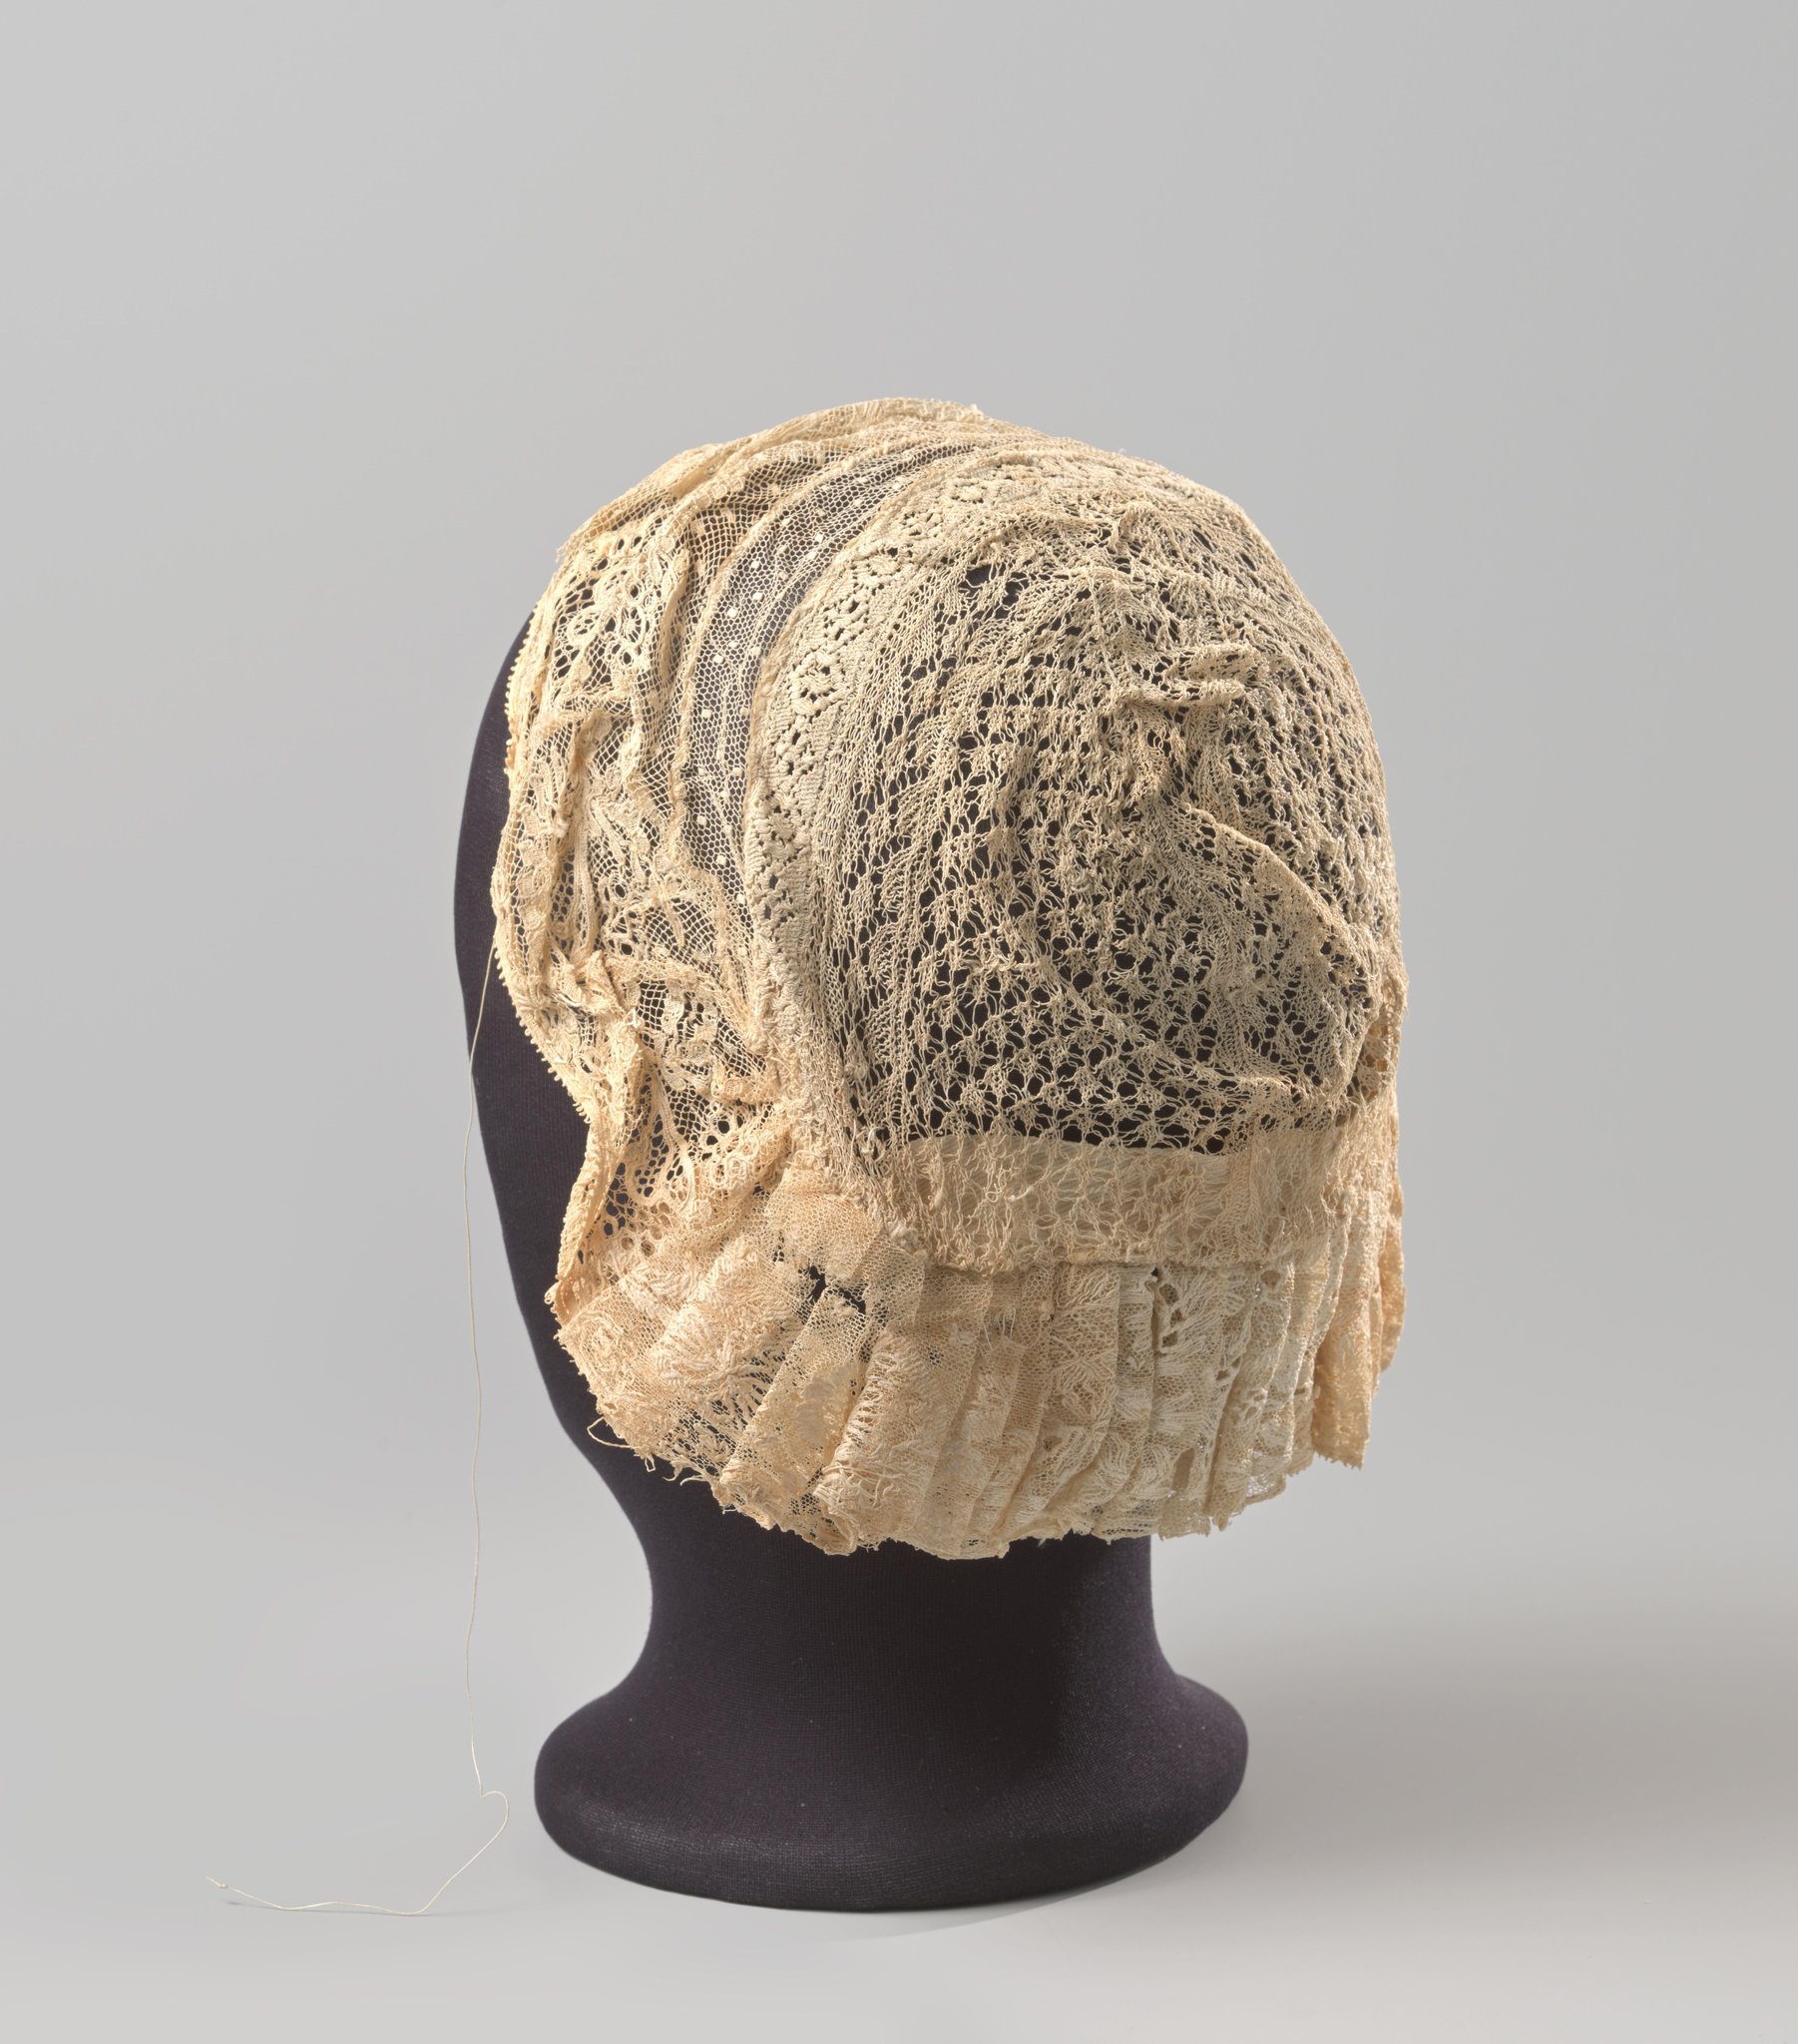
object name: womenswear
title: Muts met bol van Friese kant in fijn breiwerk, afgezet met een strook Rijsselse kant dat langs het voorhoofd geplooid is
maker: Anonymous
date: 1800-1900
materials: linen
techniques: material, knitting, lace, needleworking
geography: friesland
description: Muts met bol van Friese kant in fijn breiwerk, afgezet met een strook Rijsselse kant dat langs het voorhoofd geplooid is.